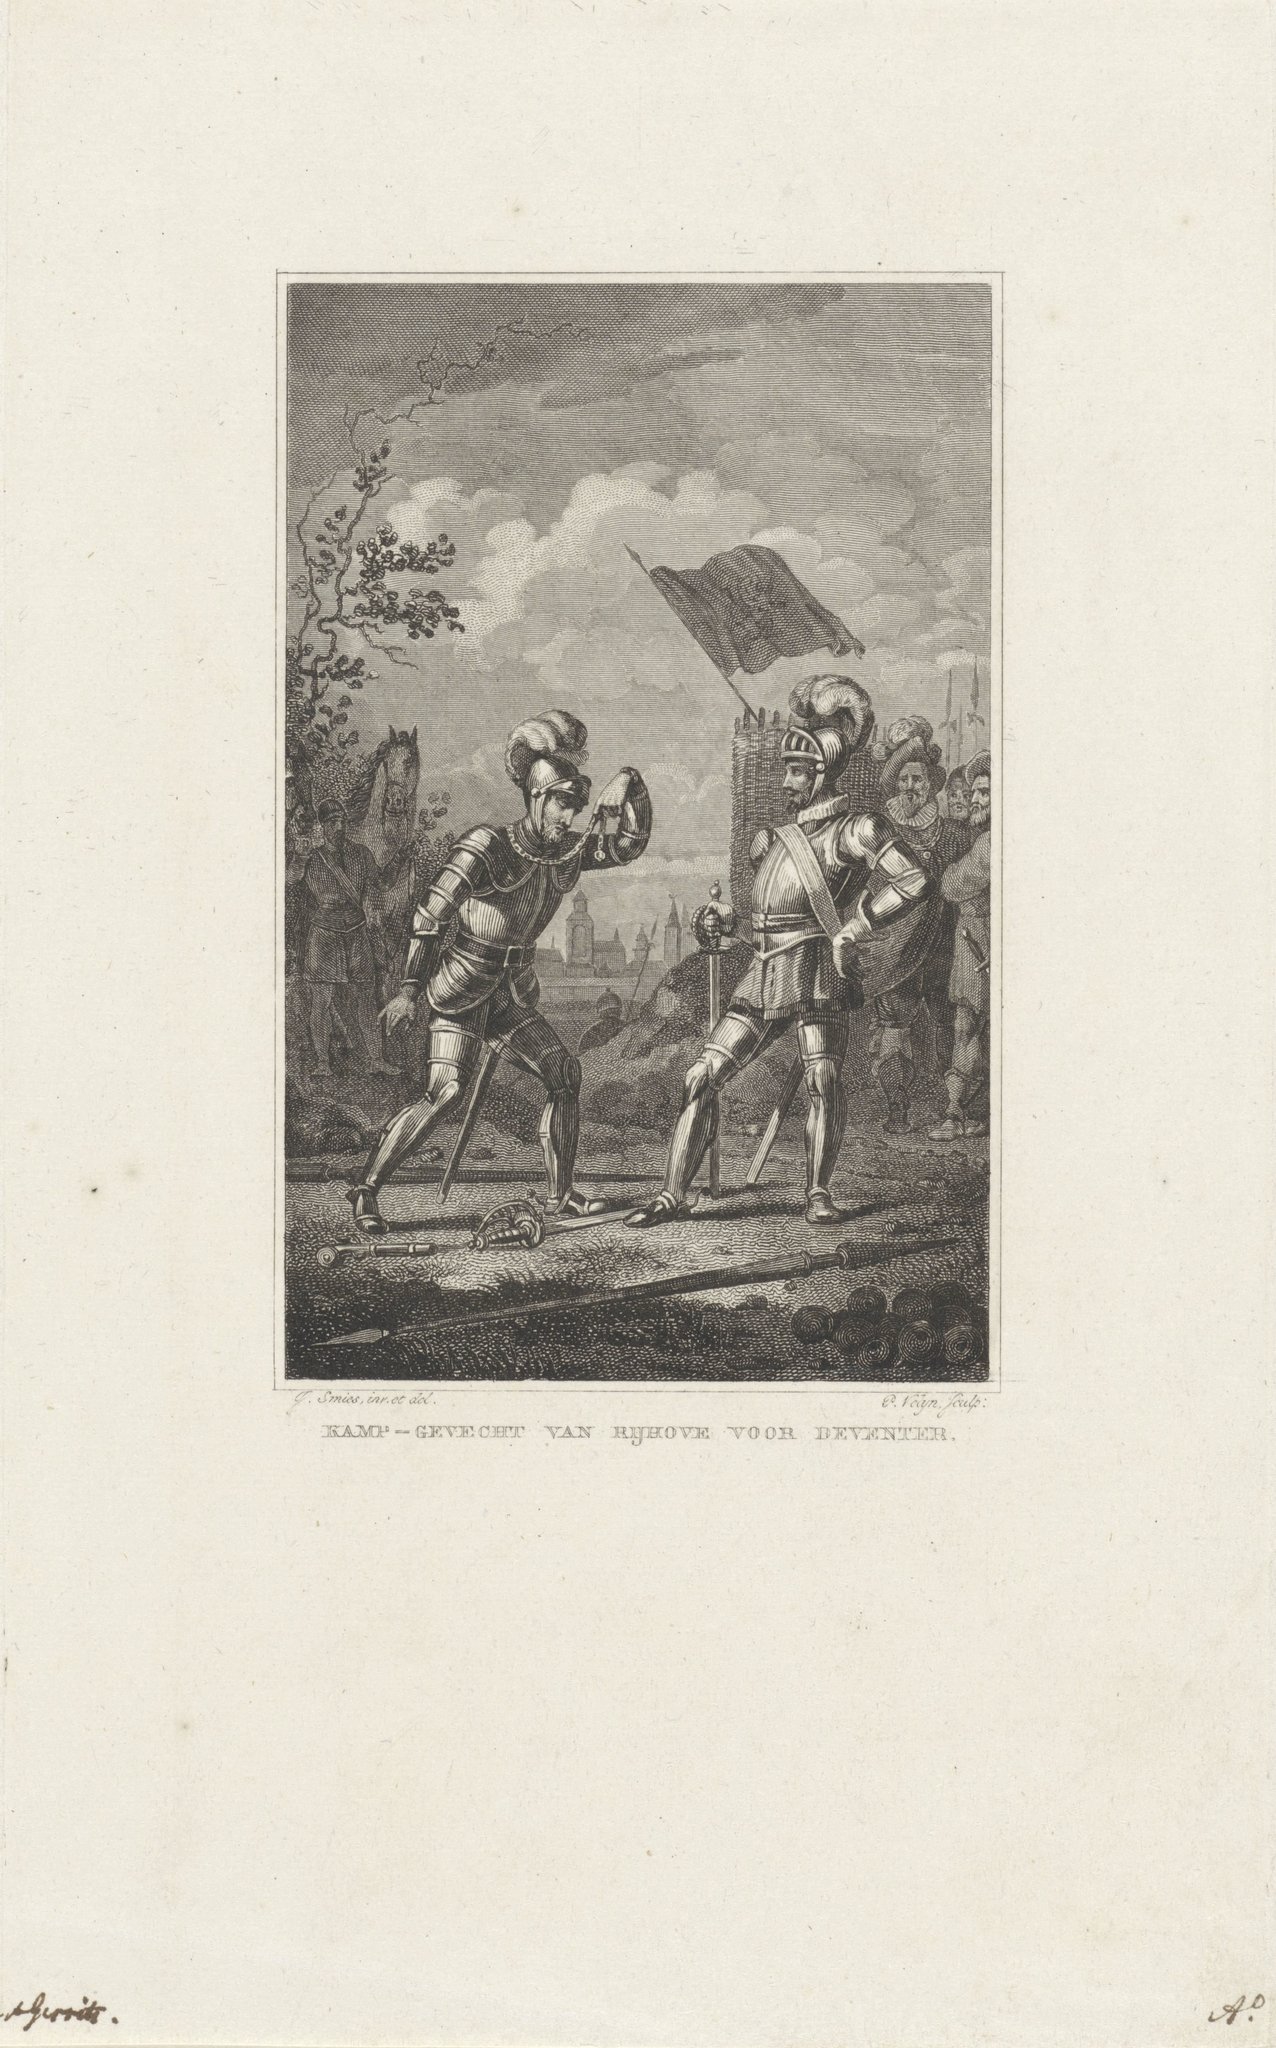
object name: print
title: Lodewijk van der Kethulle verslaat de Spaanse ruiter, 1591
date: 1827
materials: paper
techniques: etching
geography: netherlands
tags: duelling, deventer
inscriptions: collector's mark: Lugt 2228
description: Prent gebruikt als boekillustratie in: P.G. Witsen Geysbeek en G. Engelberts Gerrits. Schoonheden en merkwaardige tafereelen uit de Nederlandsche geschiedenis. 8 delen. Amsterdam: G. Portielje, 1825-1829. Vierde deel, 1827.